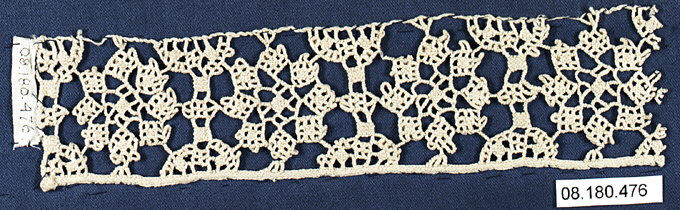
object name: border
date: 1601-1700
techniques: lace